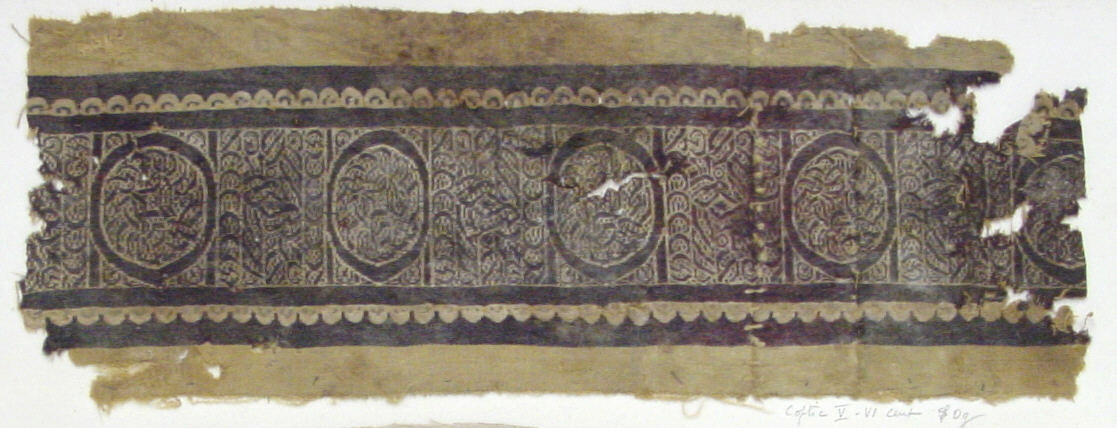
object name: textile fragment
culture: coptic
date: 401-600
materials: linen, wool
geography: egypt